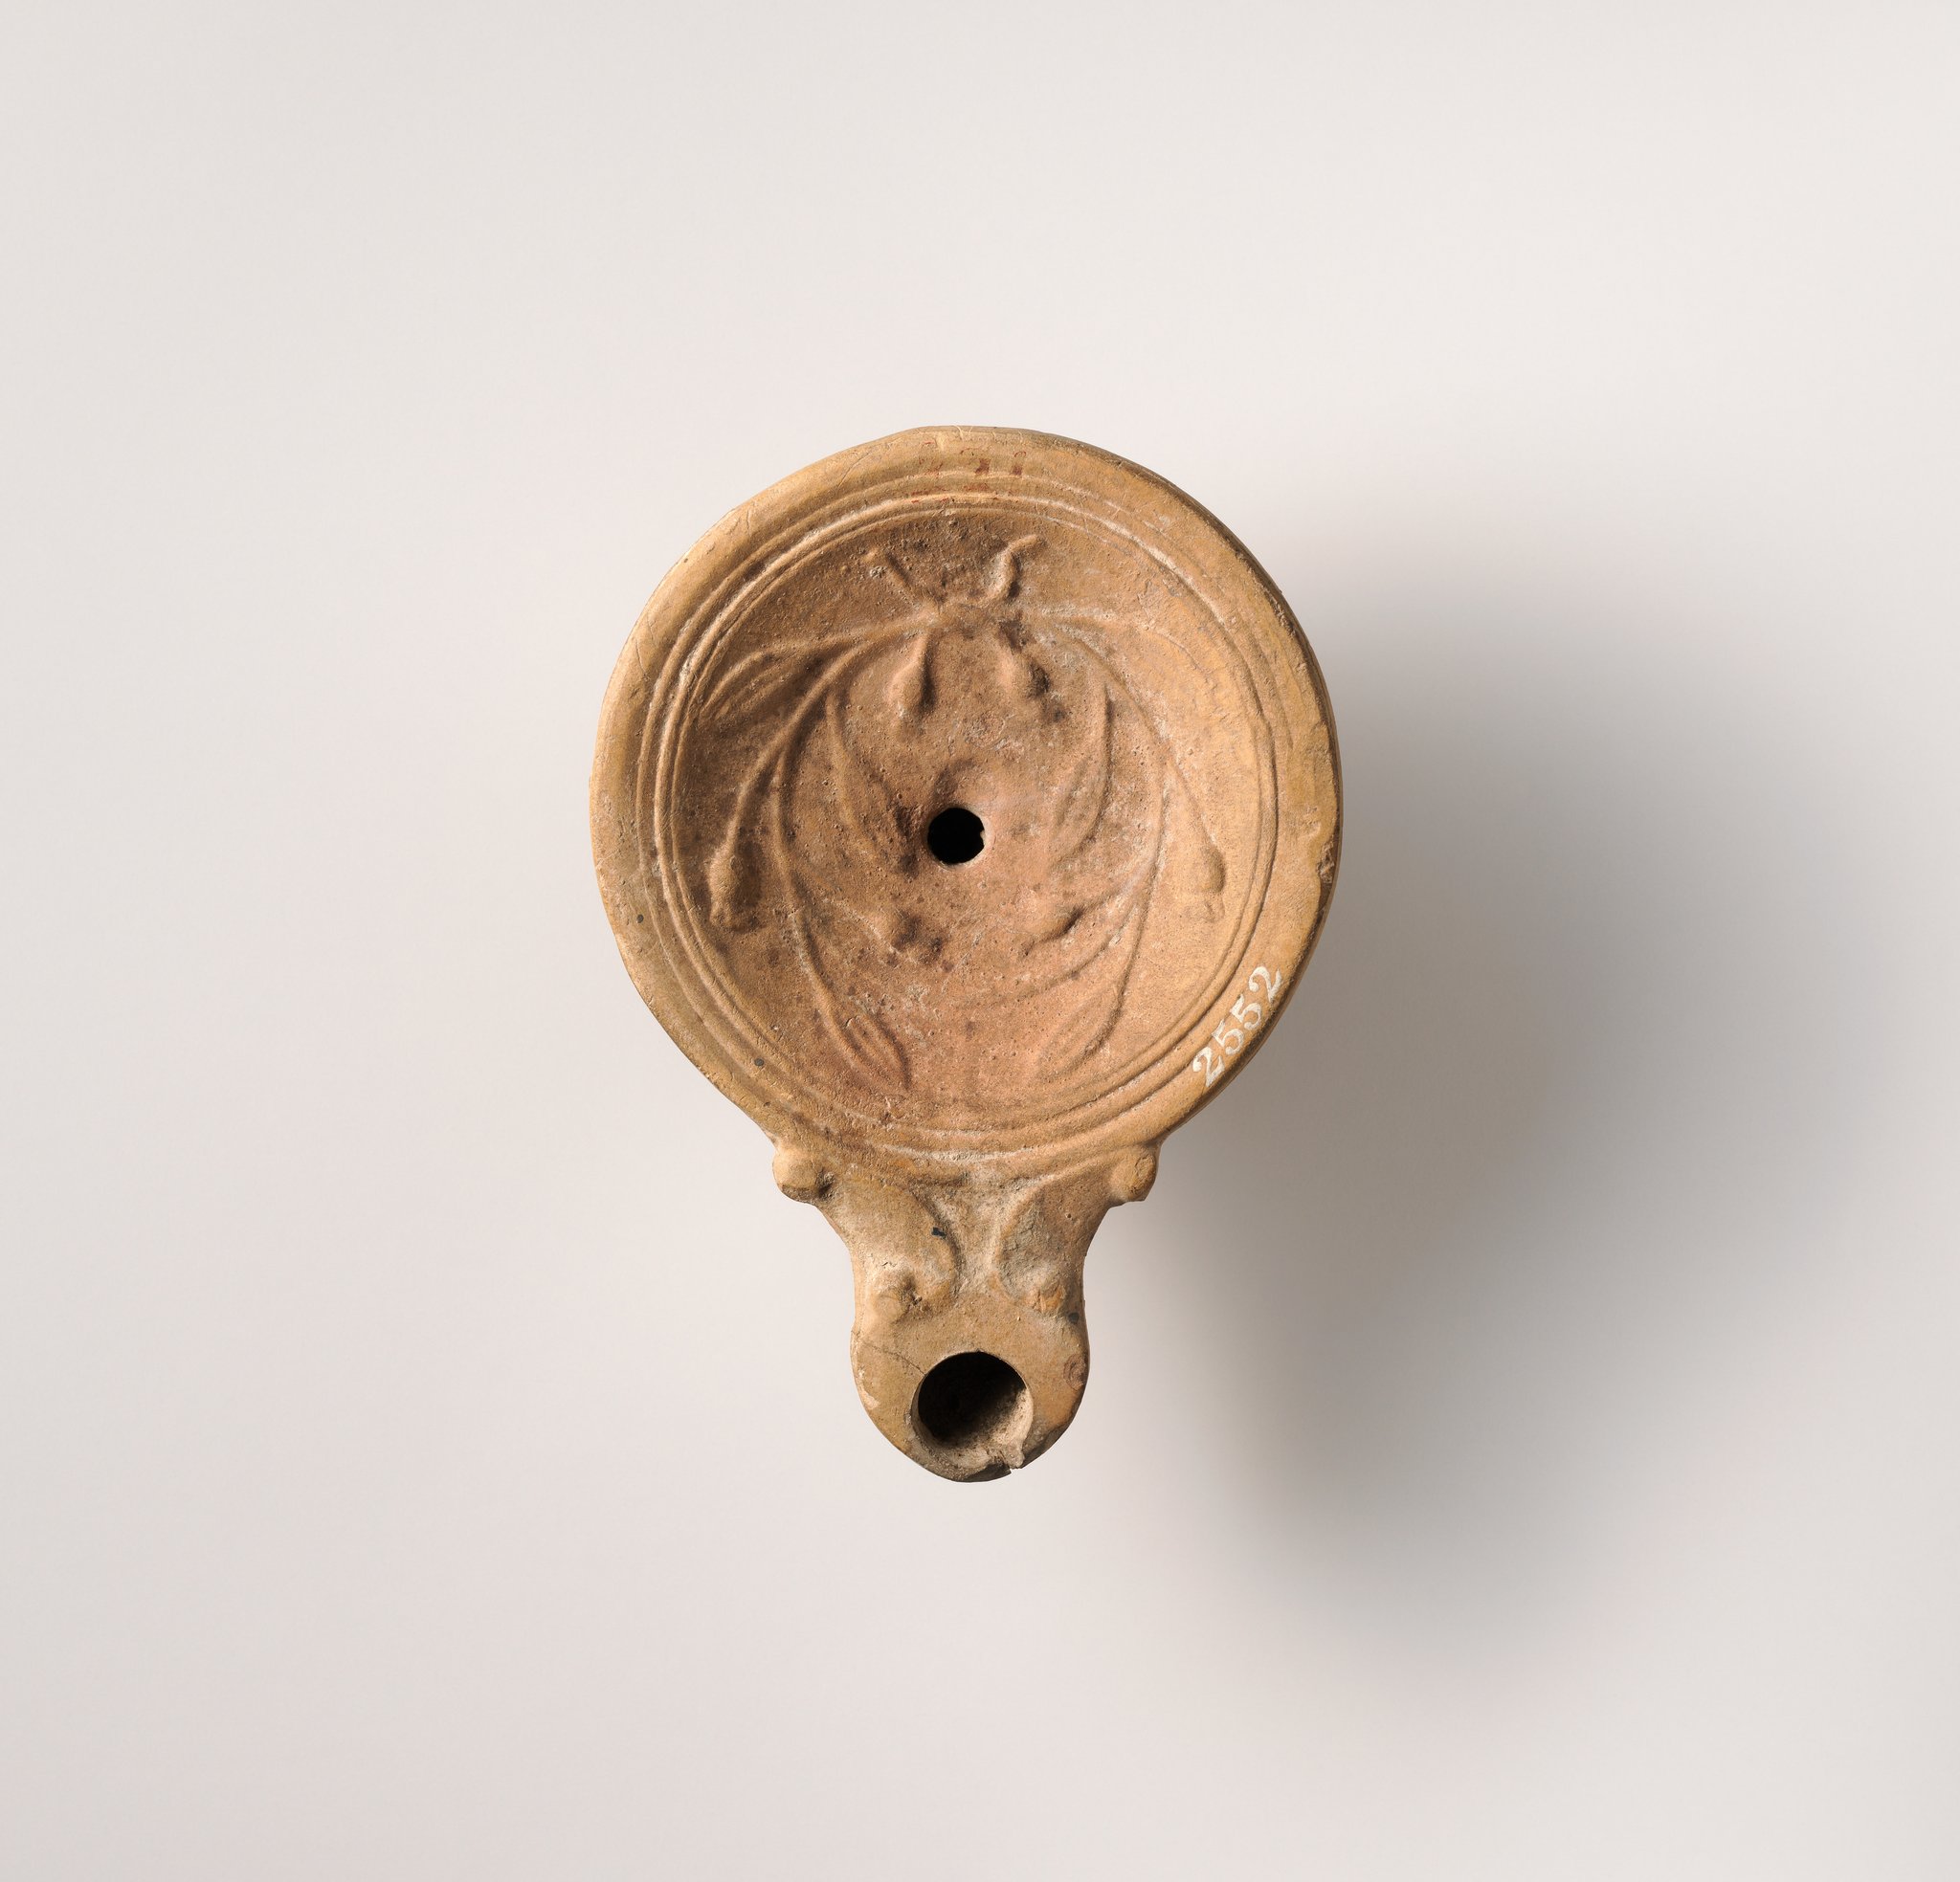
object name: lamp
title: Terracotta oil lamp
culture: roman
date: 51-100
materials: terracotta